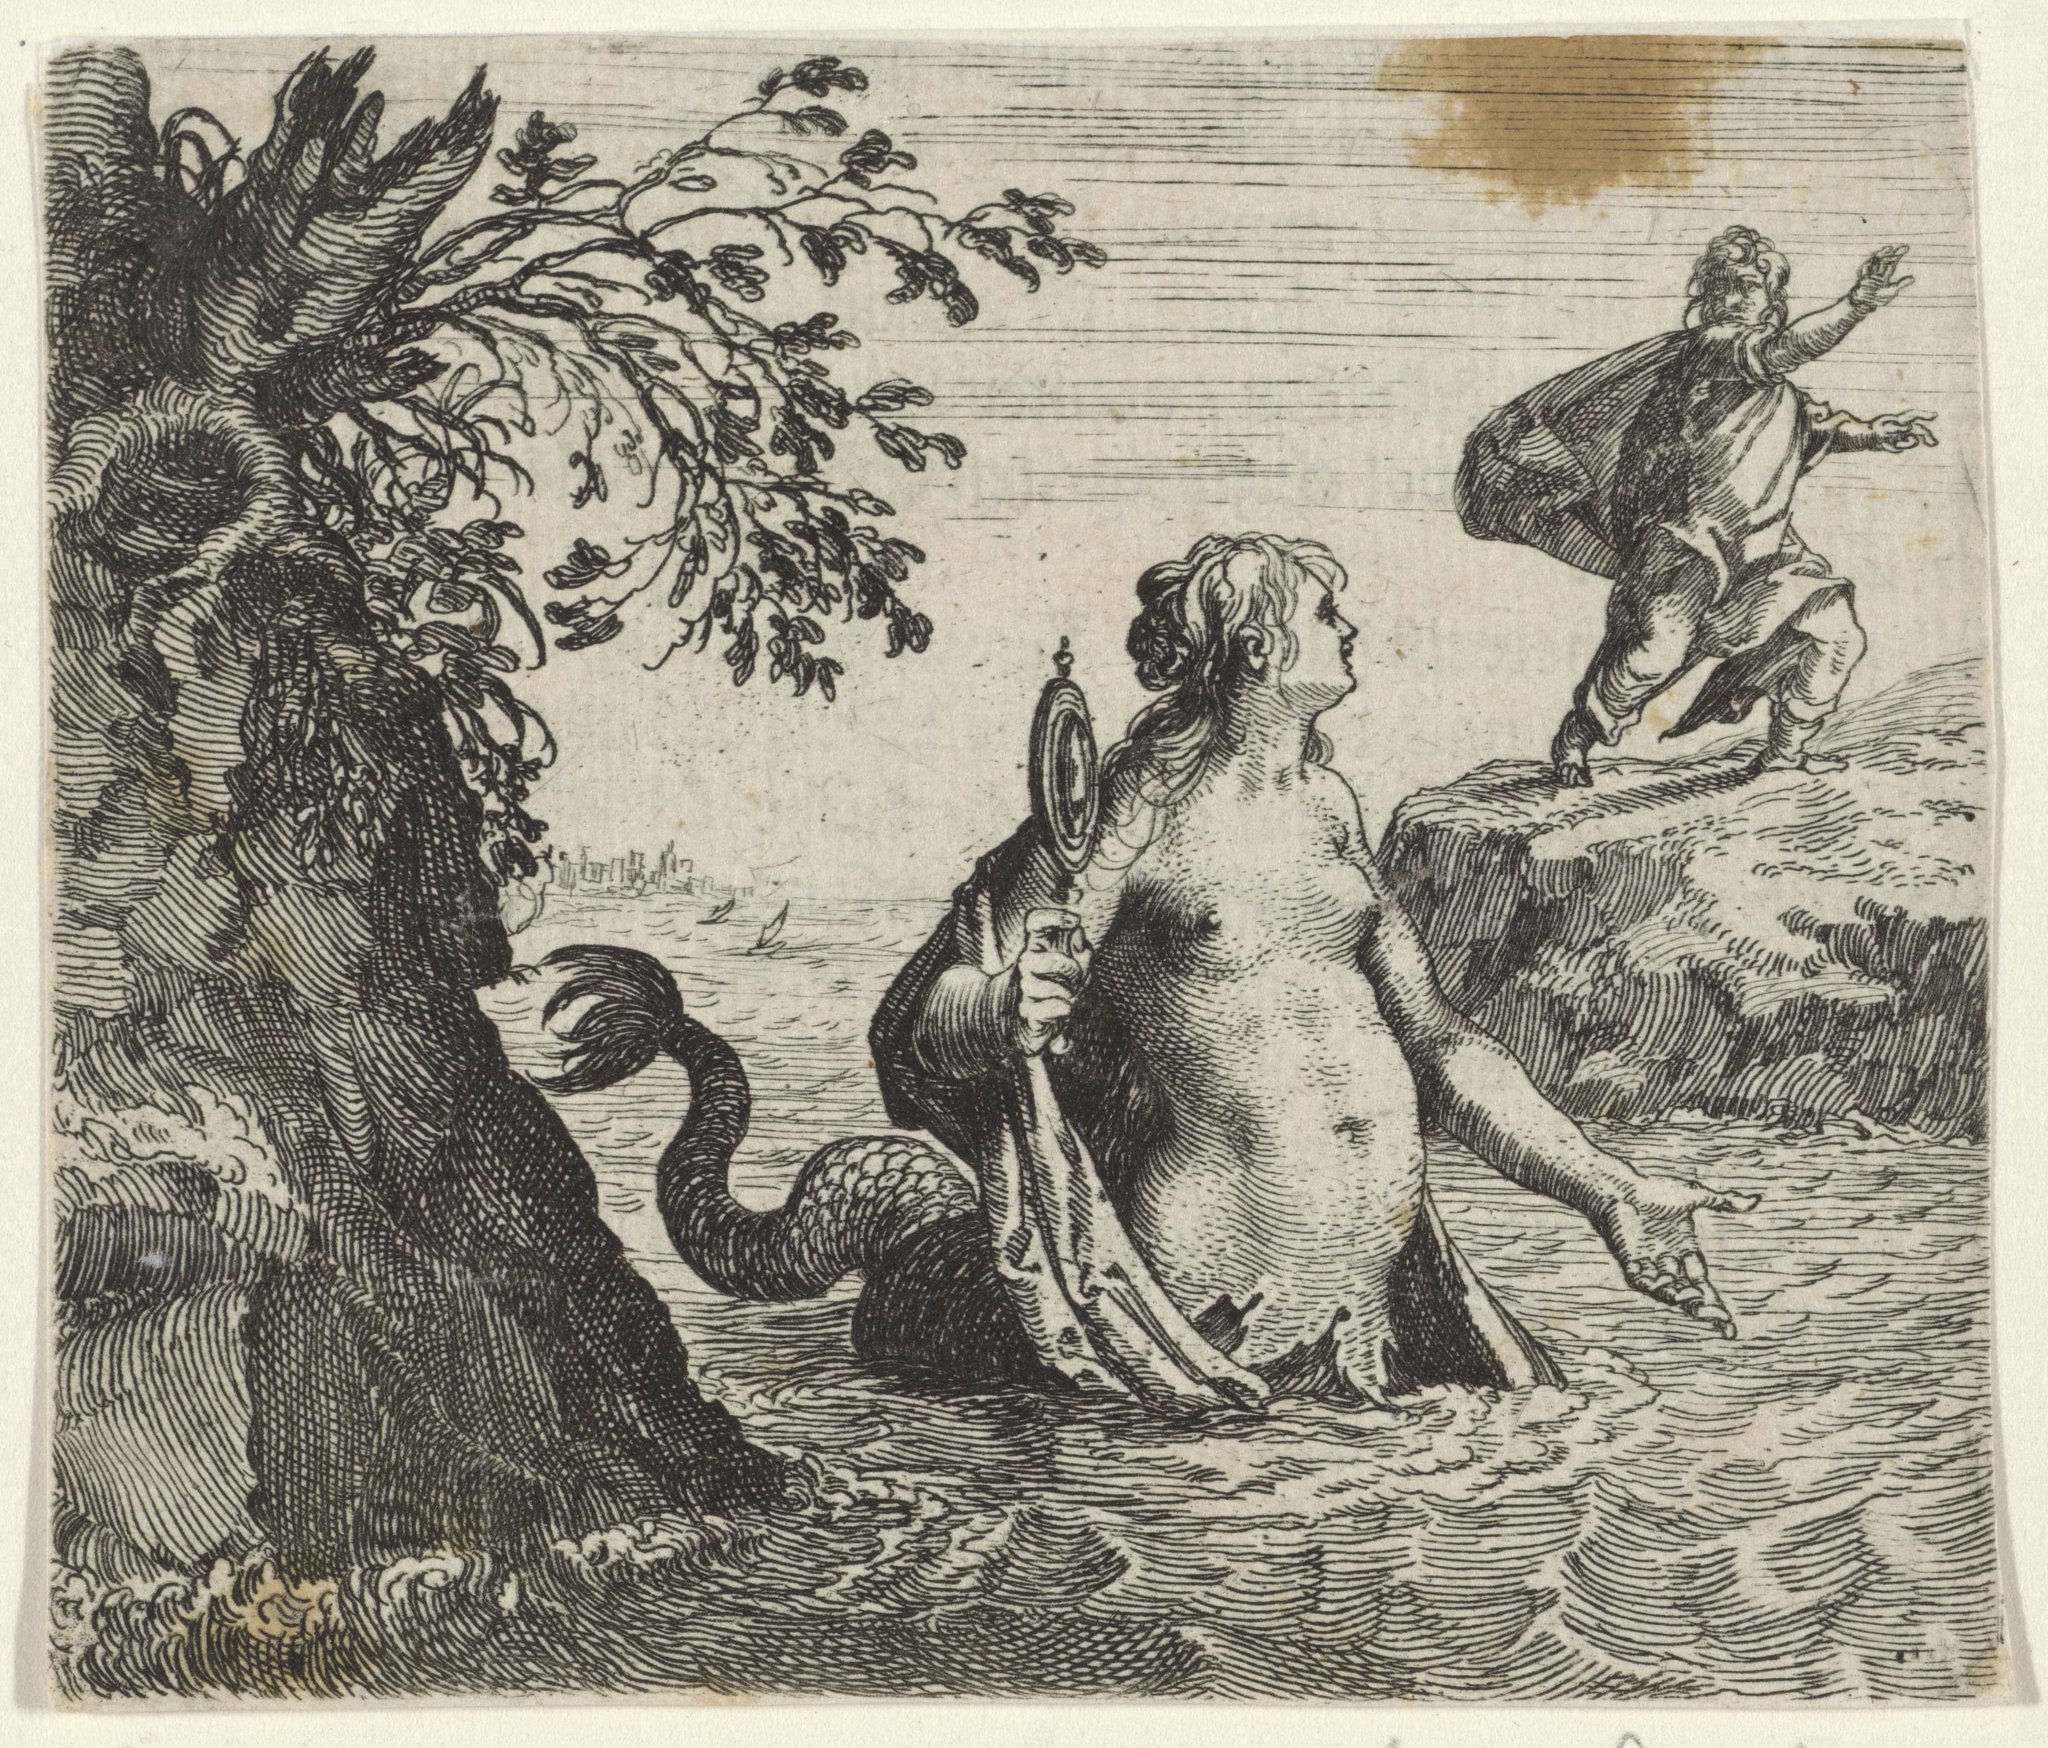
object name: book illustration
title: Fabel van de zeemeermin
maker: aegidius sadeler (ii)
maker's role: draughtsman, print maker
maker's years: 1568-1629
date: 1608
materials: paper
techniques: engraving, etching, letterpress printing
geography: prague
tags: merman - aa - mermaid, siren, fables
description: Een zeemeermin zwemt in zee en tracht een jongeling naar zich te lokken met haar gezang. In haar handen een spiegel.